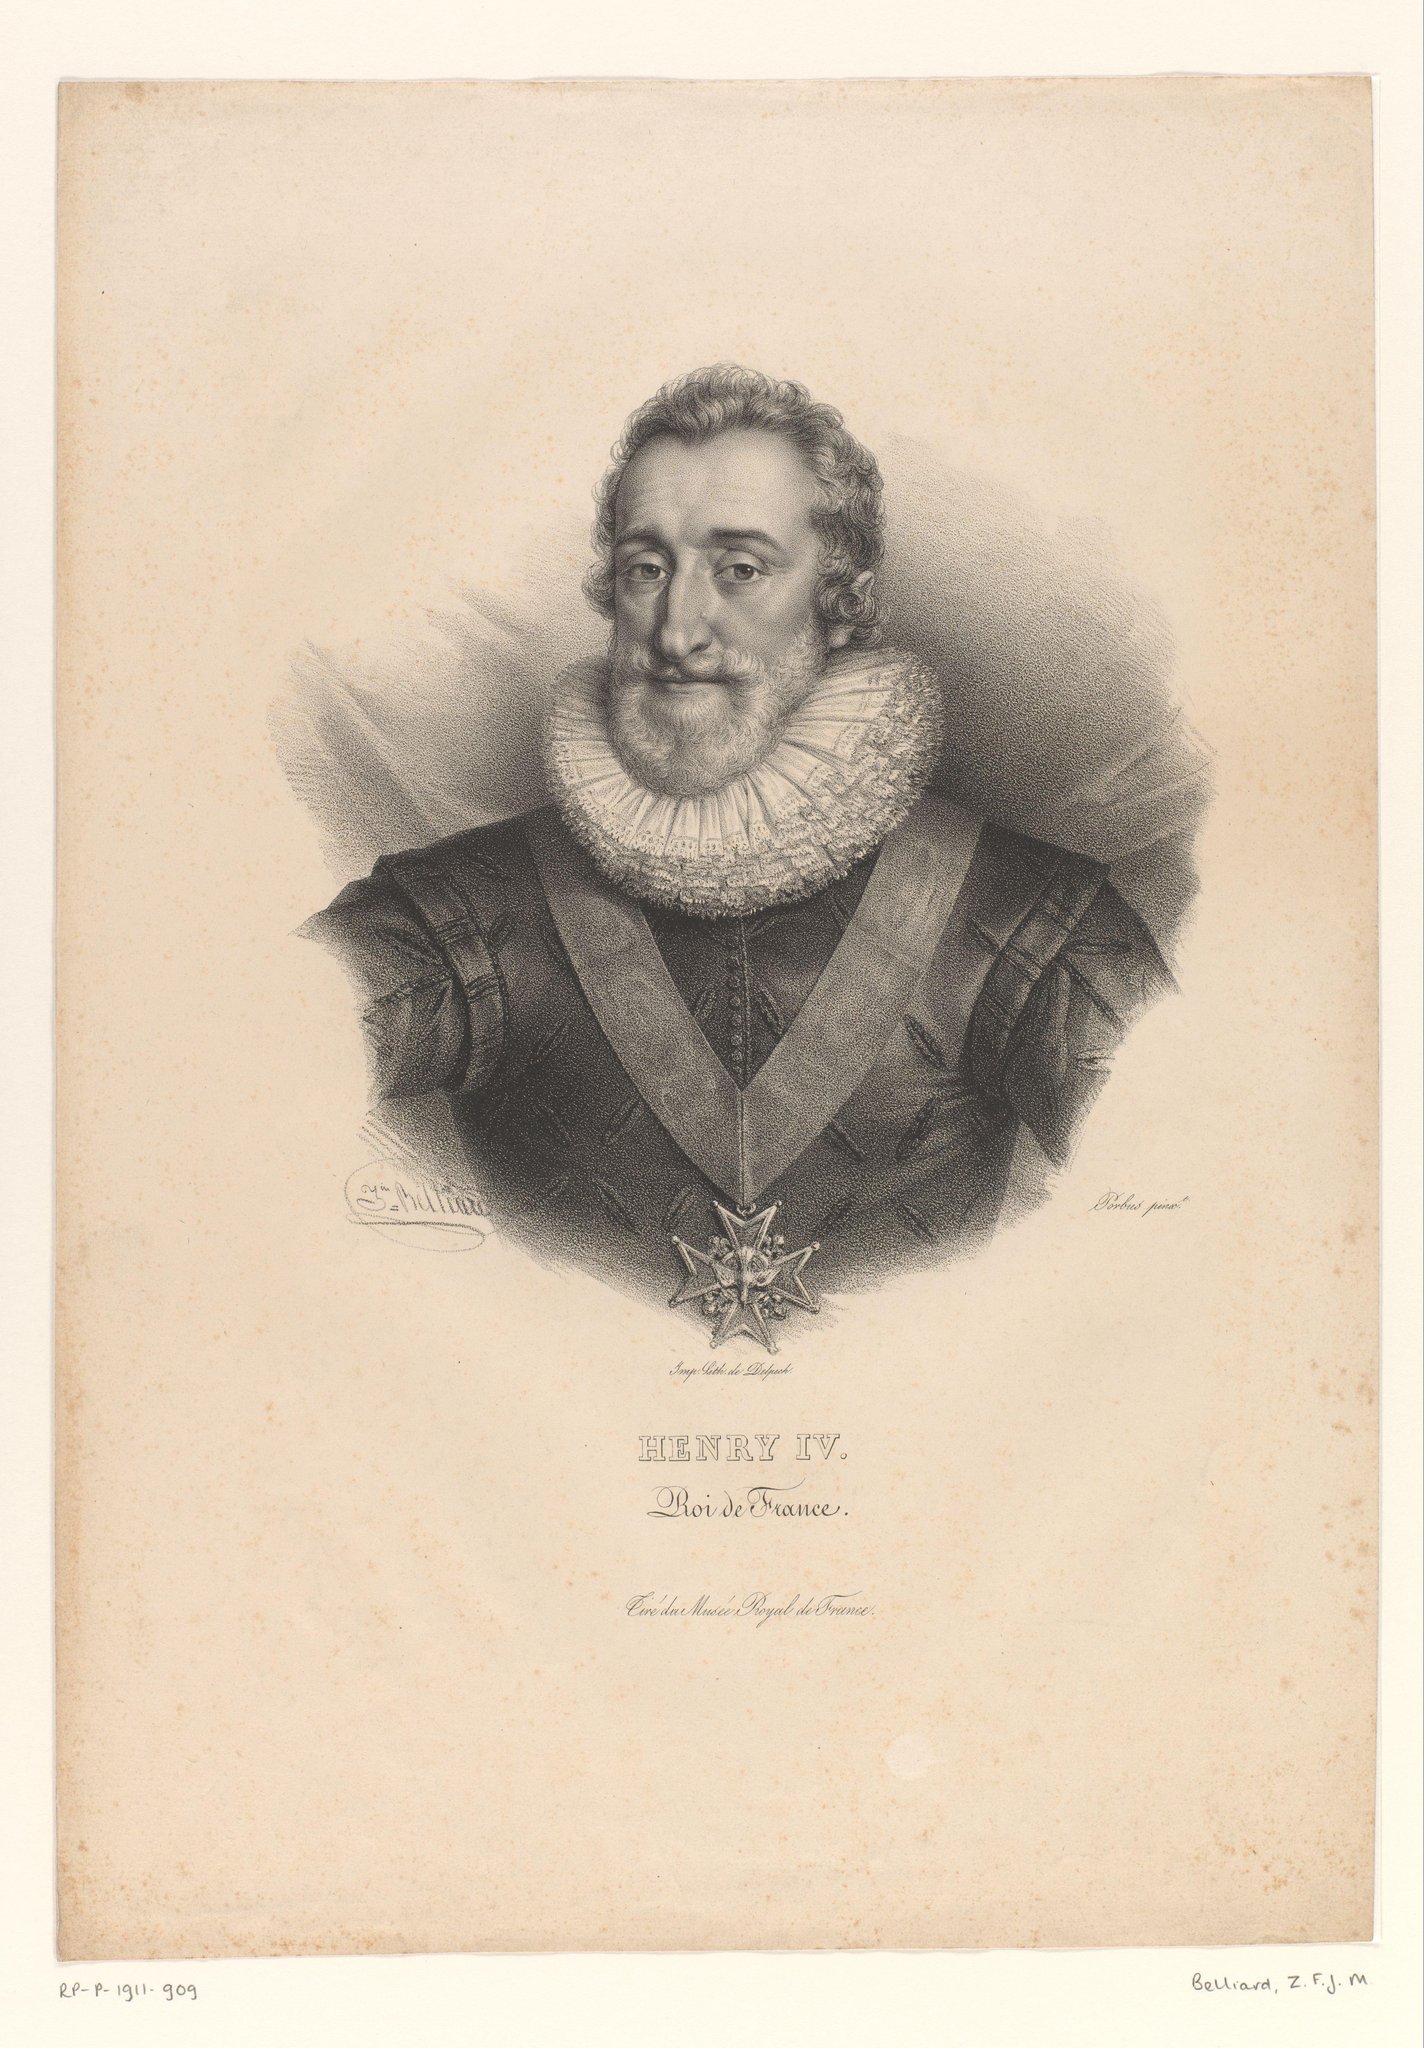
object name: book illustration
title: Tweehonderd portretten tussen de regeringsperioden van Karel VII en Lodewijk XVI van Frankrijk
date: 1828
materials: paper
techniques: lithograph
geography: paris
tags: paris, hendrik iv (koning van frankrijk en navarra), historical persons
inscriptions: collector's mark: Lugt 2228a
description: Prent gepubliceerd in: Iconographie française, ou Choix de deux cents portraits d'hommes et de femmes depuis le règne de Charles VII jusqu'à la fin de celui de Louis XVI, publié par Madame Delpech, Parijs 1840.